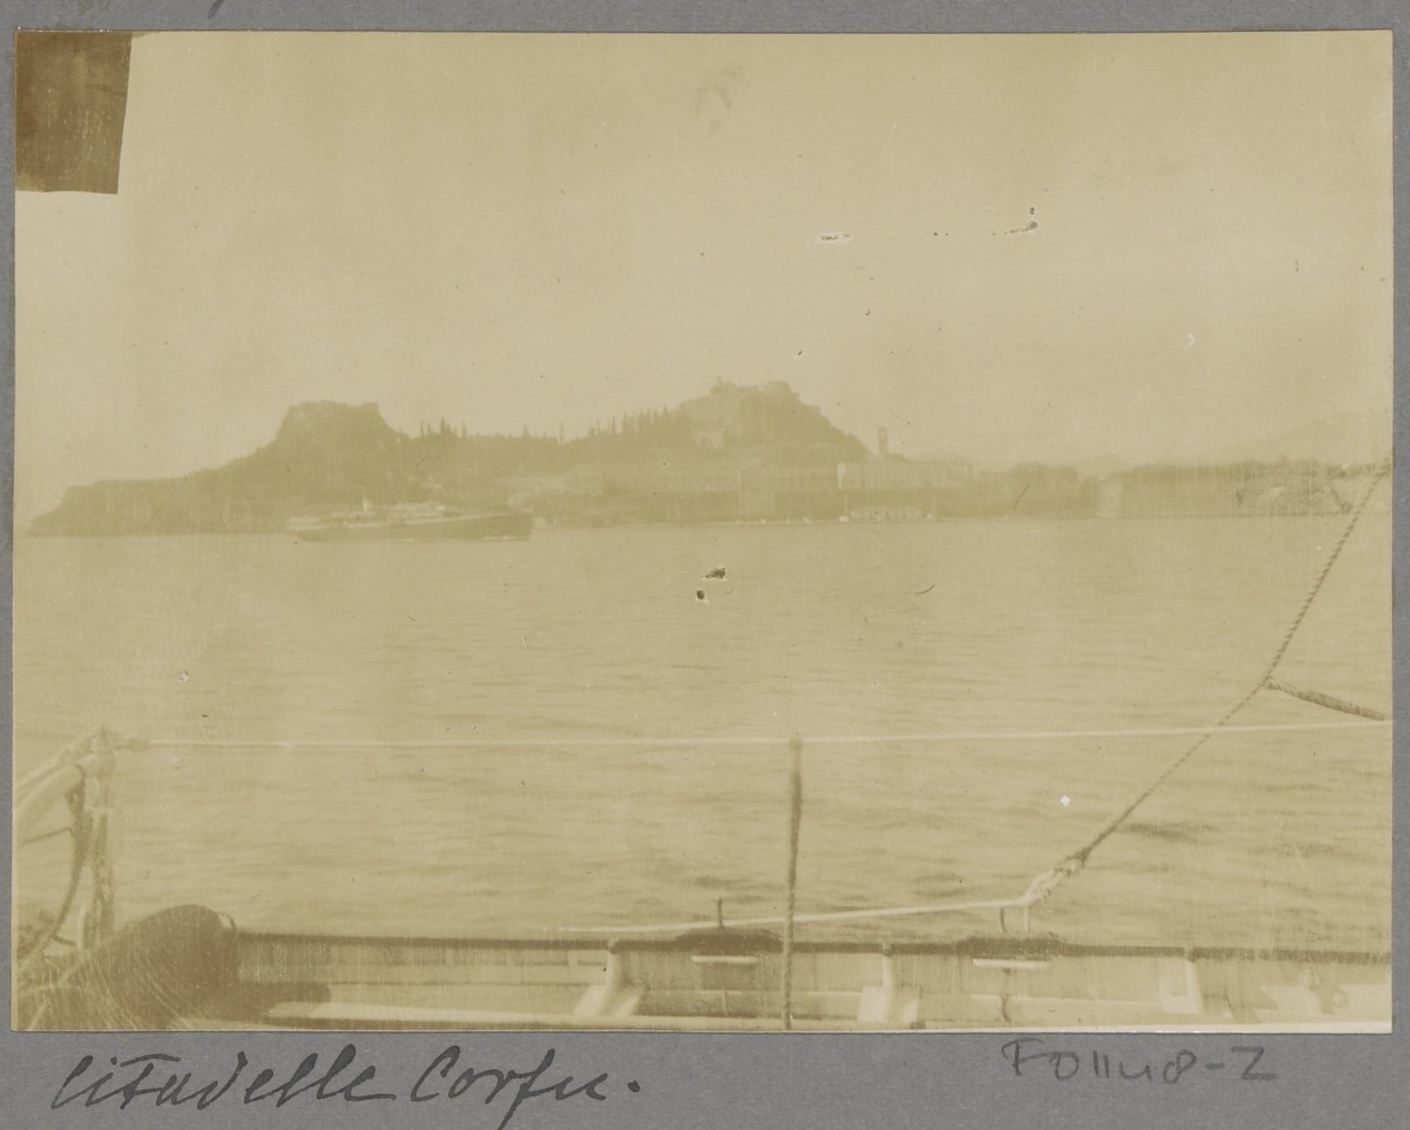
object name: photograph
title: Gezicht op de citadel van Corfu vanaf zee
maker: Anonymous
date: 1905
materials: paper, photographic support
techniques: gelatin silver print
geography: corfu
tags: fortified city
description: Onderdeel van Reisalbum met foto's van bezienswaardigheden in Griekenland en Egypte.